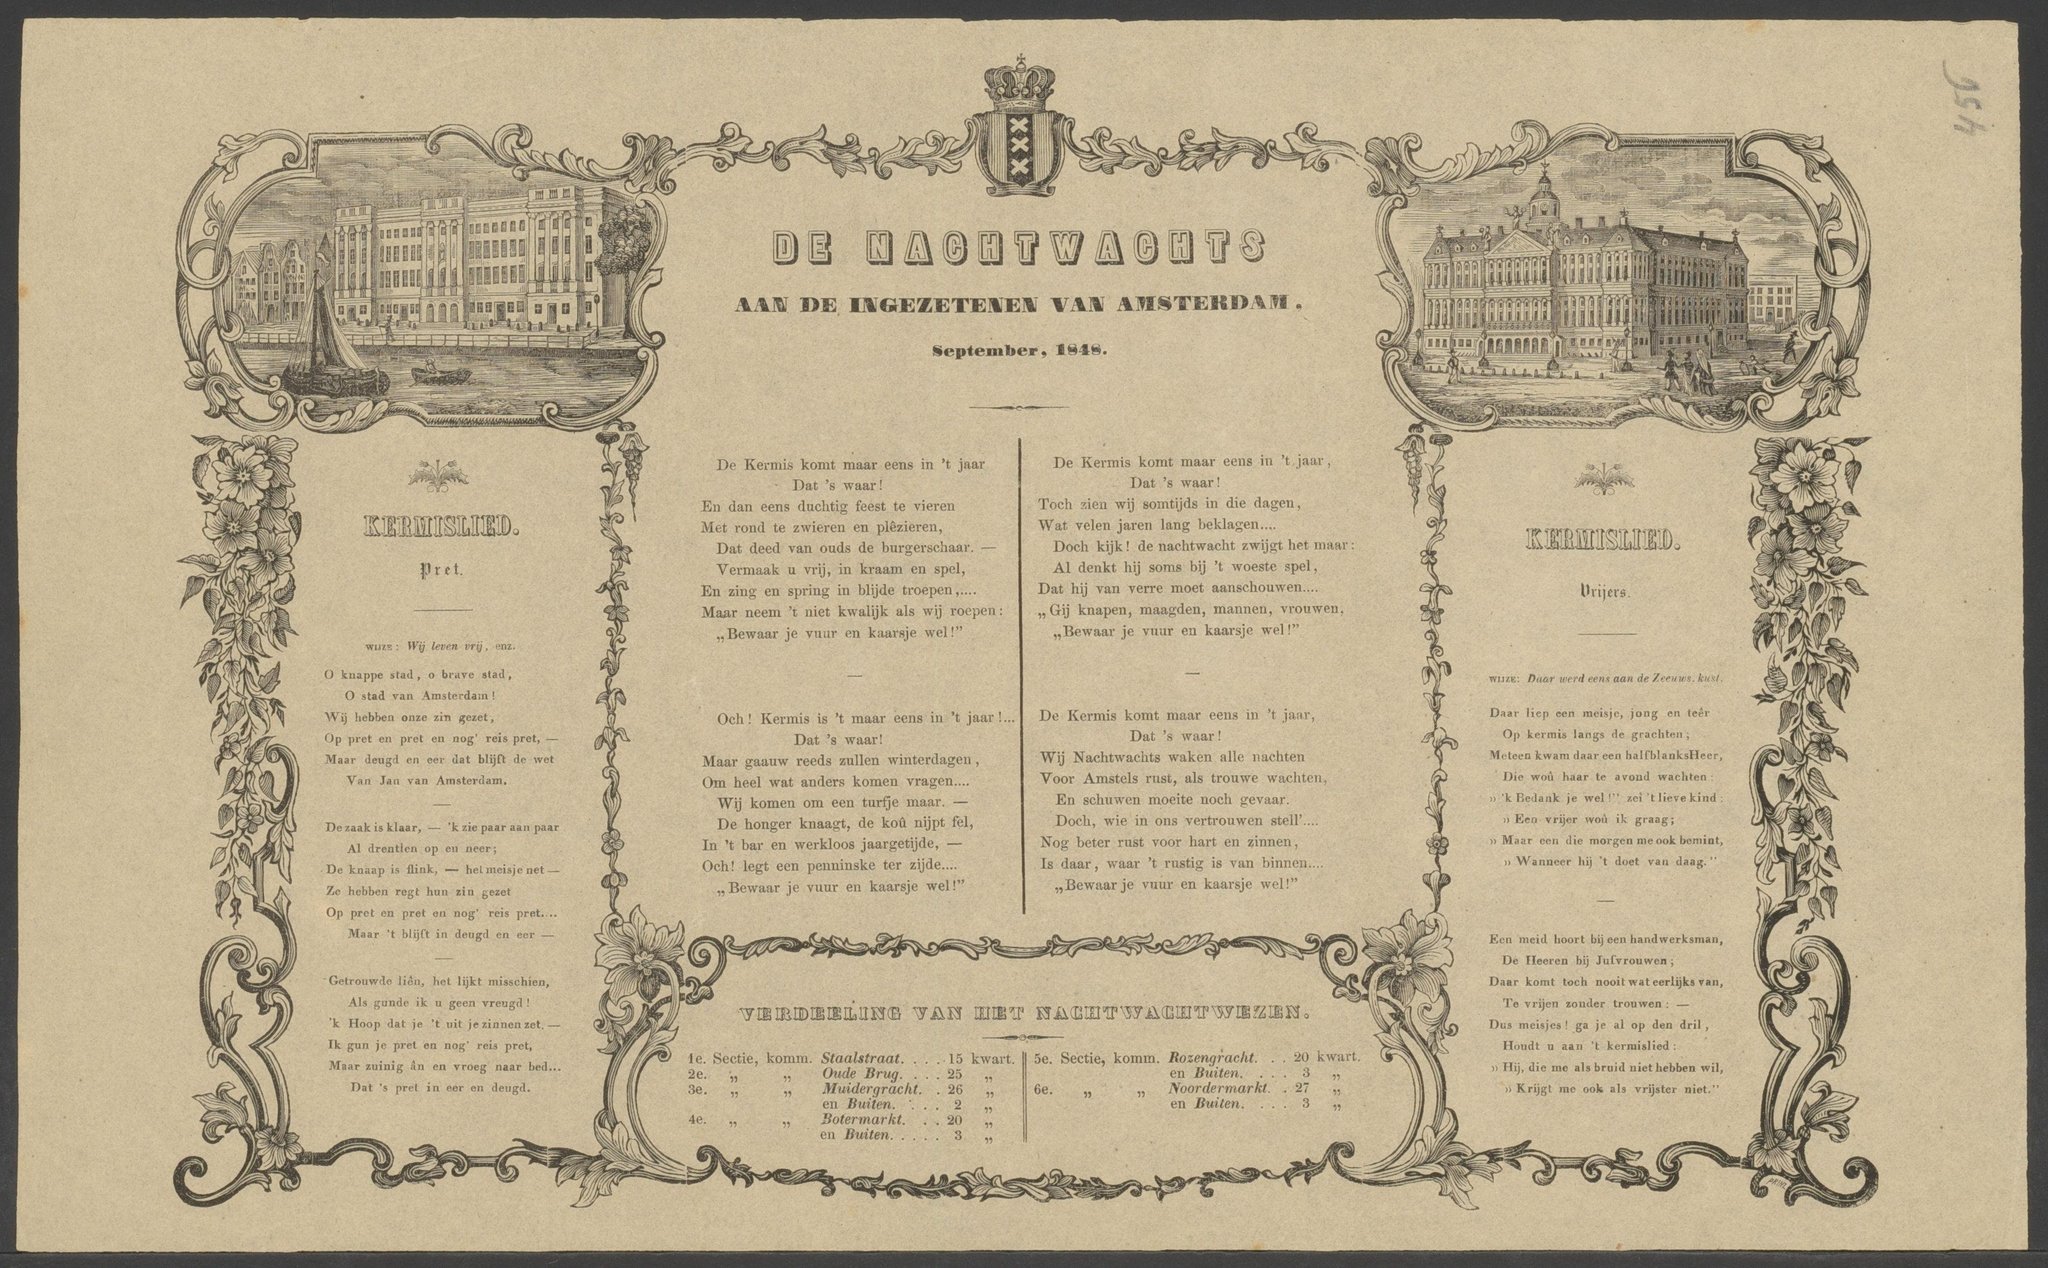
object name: print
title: Kermisprent van de Amsterdamse nachtwacht voor het jaar 1848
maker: Anonymous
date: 1848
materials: paper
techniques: letterpress printing, engraving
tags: night patrol, palace, amsterdam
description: Kermisprent van de Amsterdamse nachtwacht, september 1848. Centraal een gedicht en aan beide zijde een kermislied. Onderwerpsrubrieken binnen de Atlas Zeden en Gewoonten: Zeden en gewoonten in engeren zin, Volksleven, Volksbladen, Nieuwjaars- en Kerstwenschen, Amsterdam.